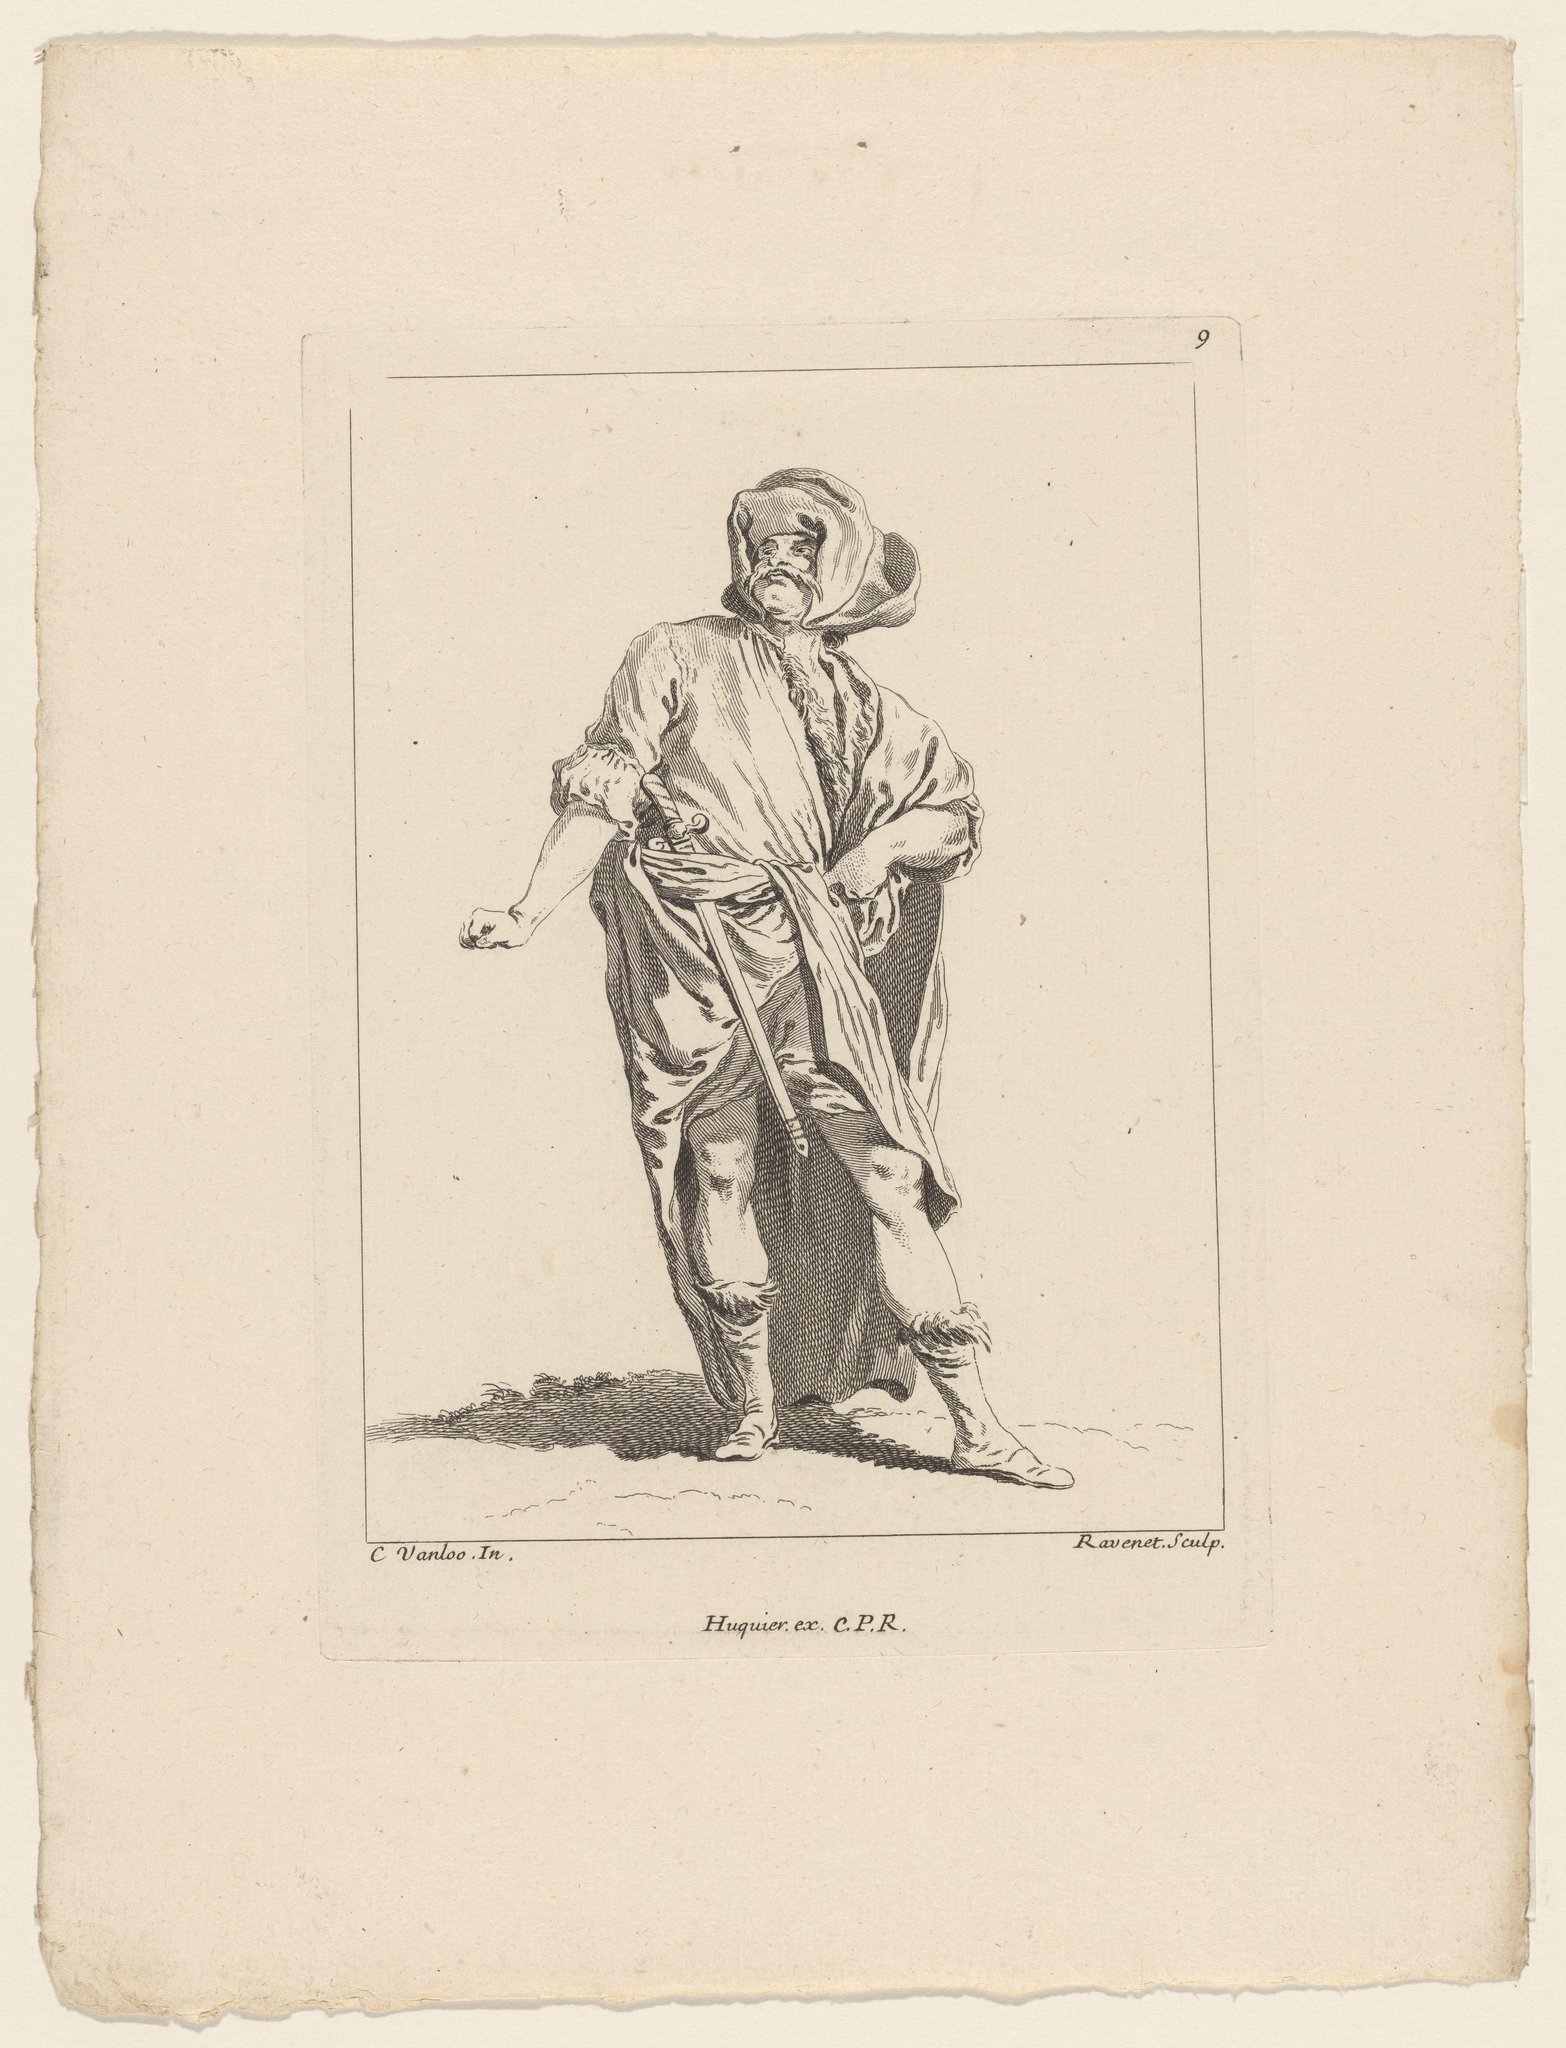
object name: print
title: Staande man met hand in de zij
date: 1732-1740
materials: paper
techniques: etching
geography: rome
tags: passions, emotions, affections, asiatic races and peoples (+ costume), characters (human types), actor (on the stage)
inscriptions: collector's mark: Lugt 2760, collector's mark: Lugt 2228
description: Staande man met snor, hoofddoek en lange mantel. Met uitgestoken rechterarm, de linkerhand in de zij, omhoog kijkend. Een degen in de riem gestoken, van voren gezien. Rechtsboven genummerd: 9. Onderdeel van een serie van twaalf prenten met figuren in gedramatiseerde poses, veelal gekleed in ‘Oosterse’ fantasiekostuums, naar tekeningen van Carle van Loo, gemaakt tijdens zijn verblijf in Rome (1728-1732).